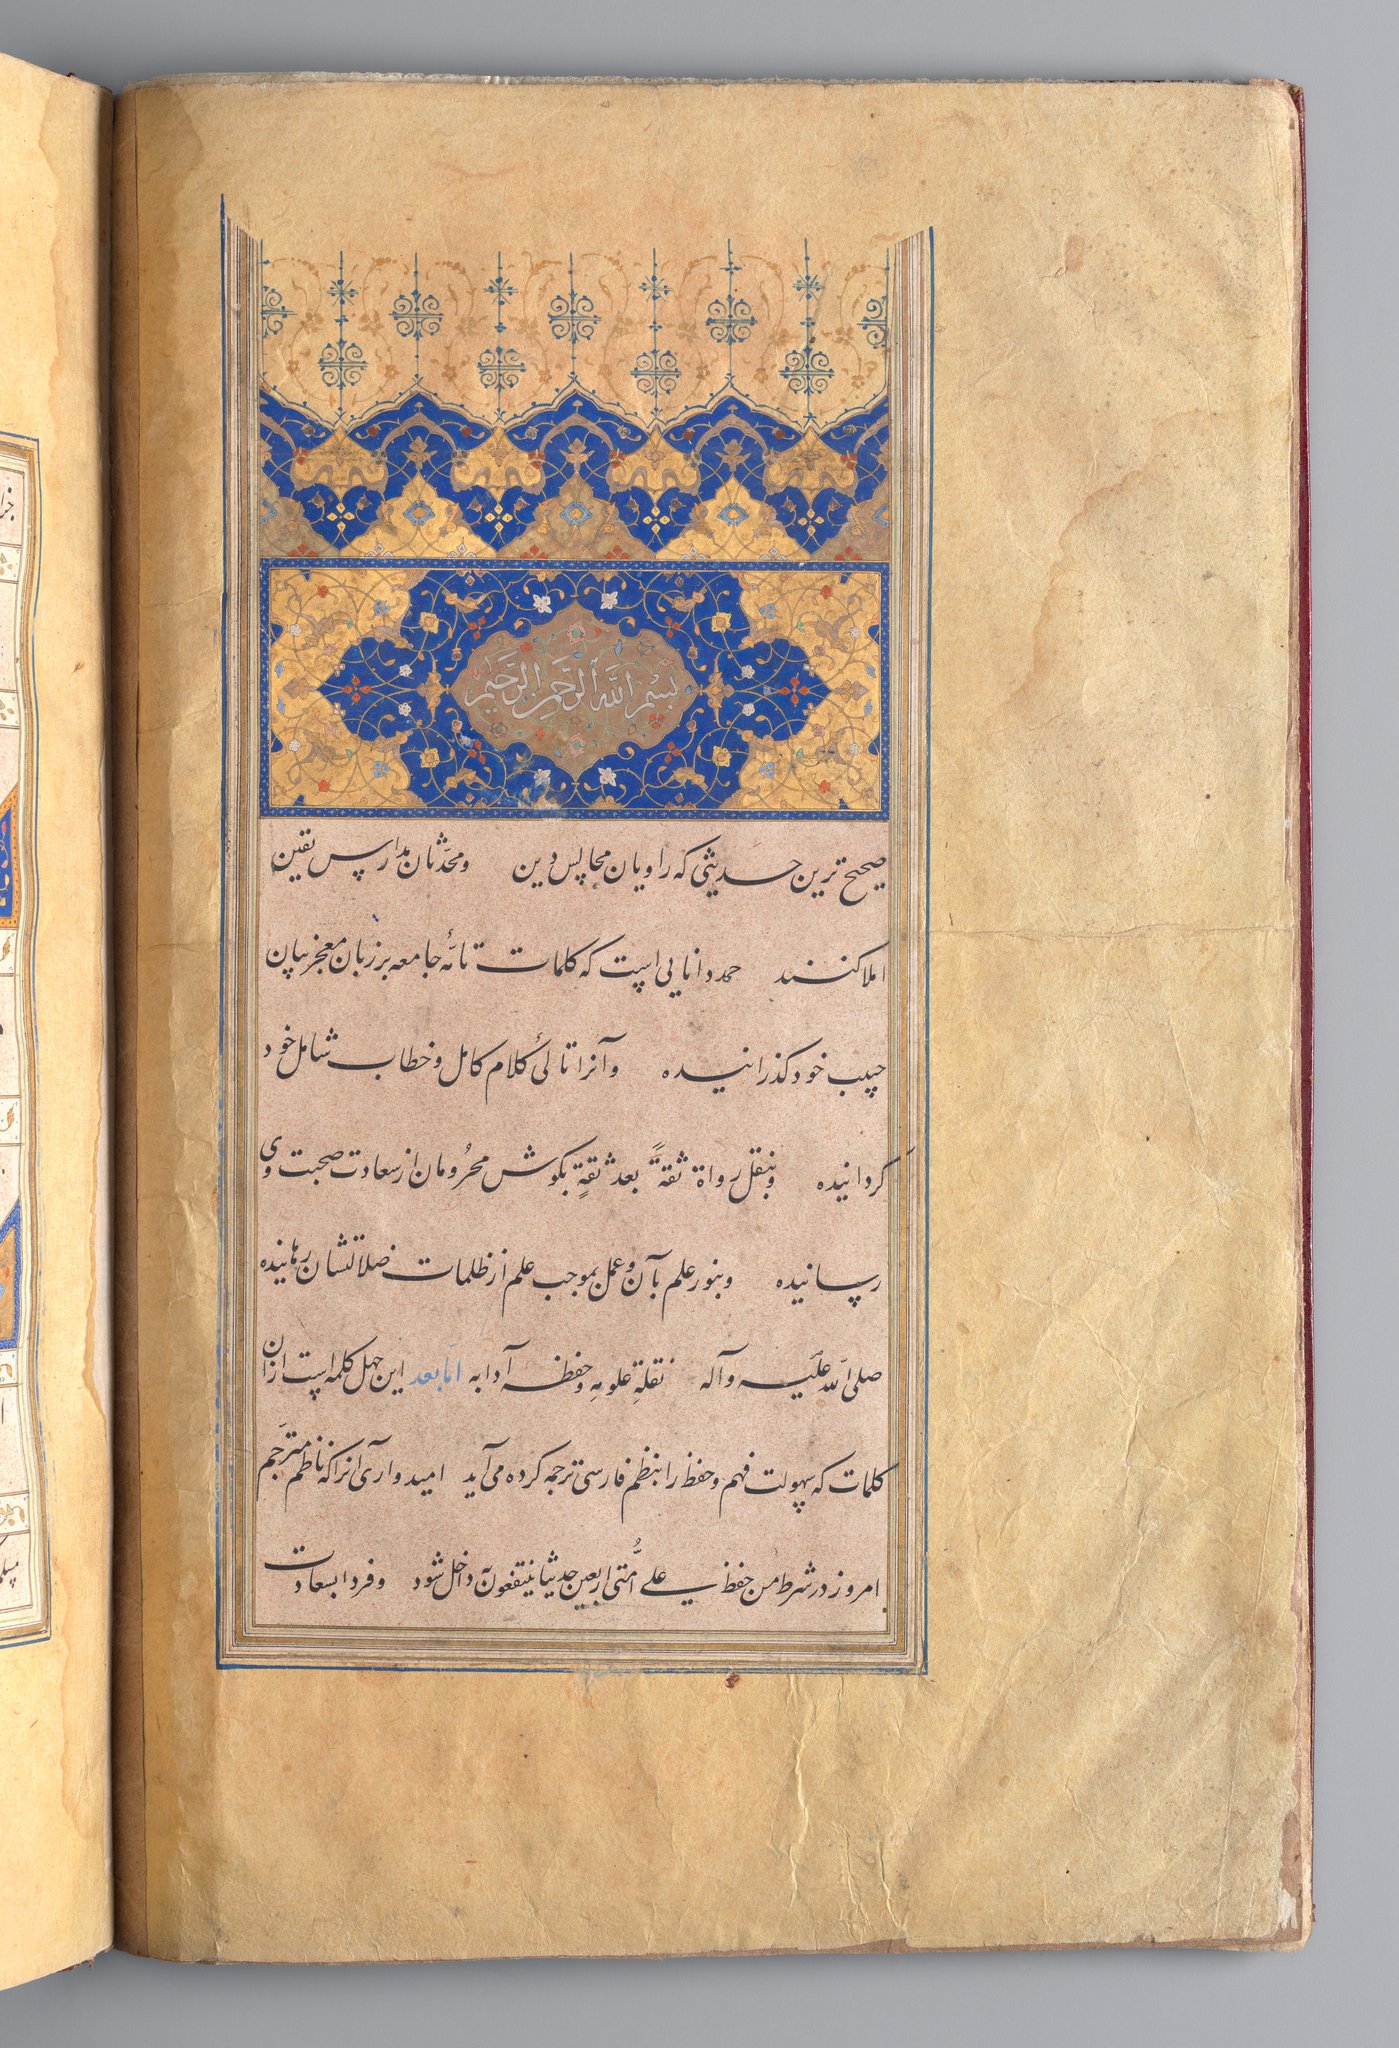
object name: non illustrated manuscript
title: Bound Manuscript of Hadith with Persian Translations by Jami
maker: shah mahmud nishapuri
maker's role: calligrapher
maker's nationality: iranian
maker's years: 1486-1565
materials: gold, ink, leather, paper, watercolor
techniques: bookbinding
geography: iran